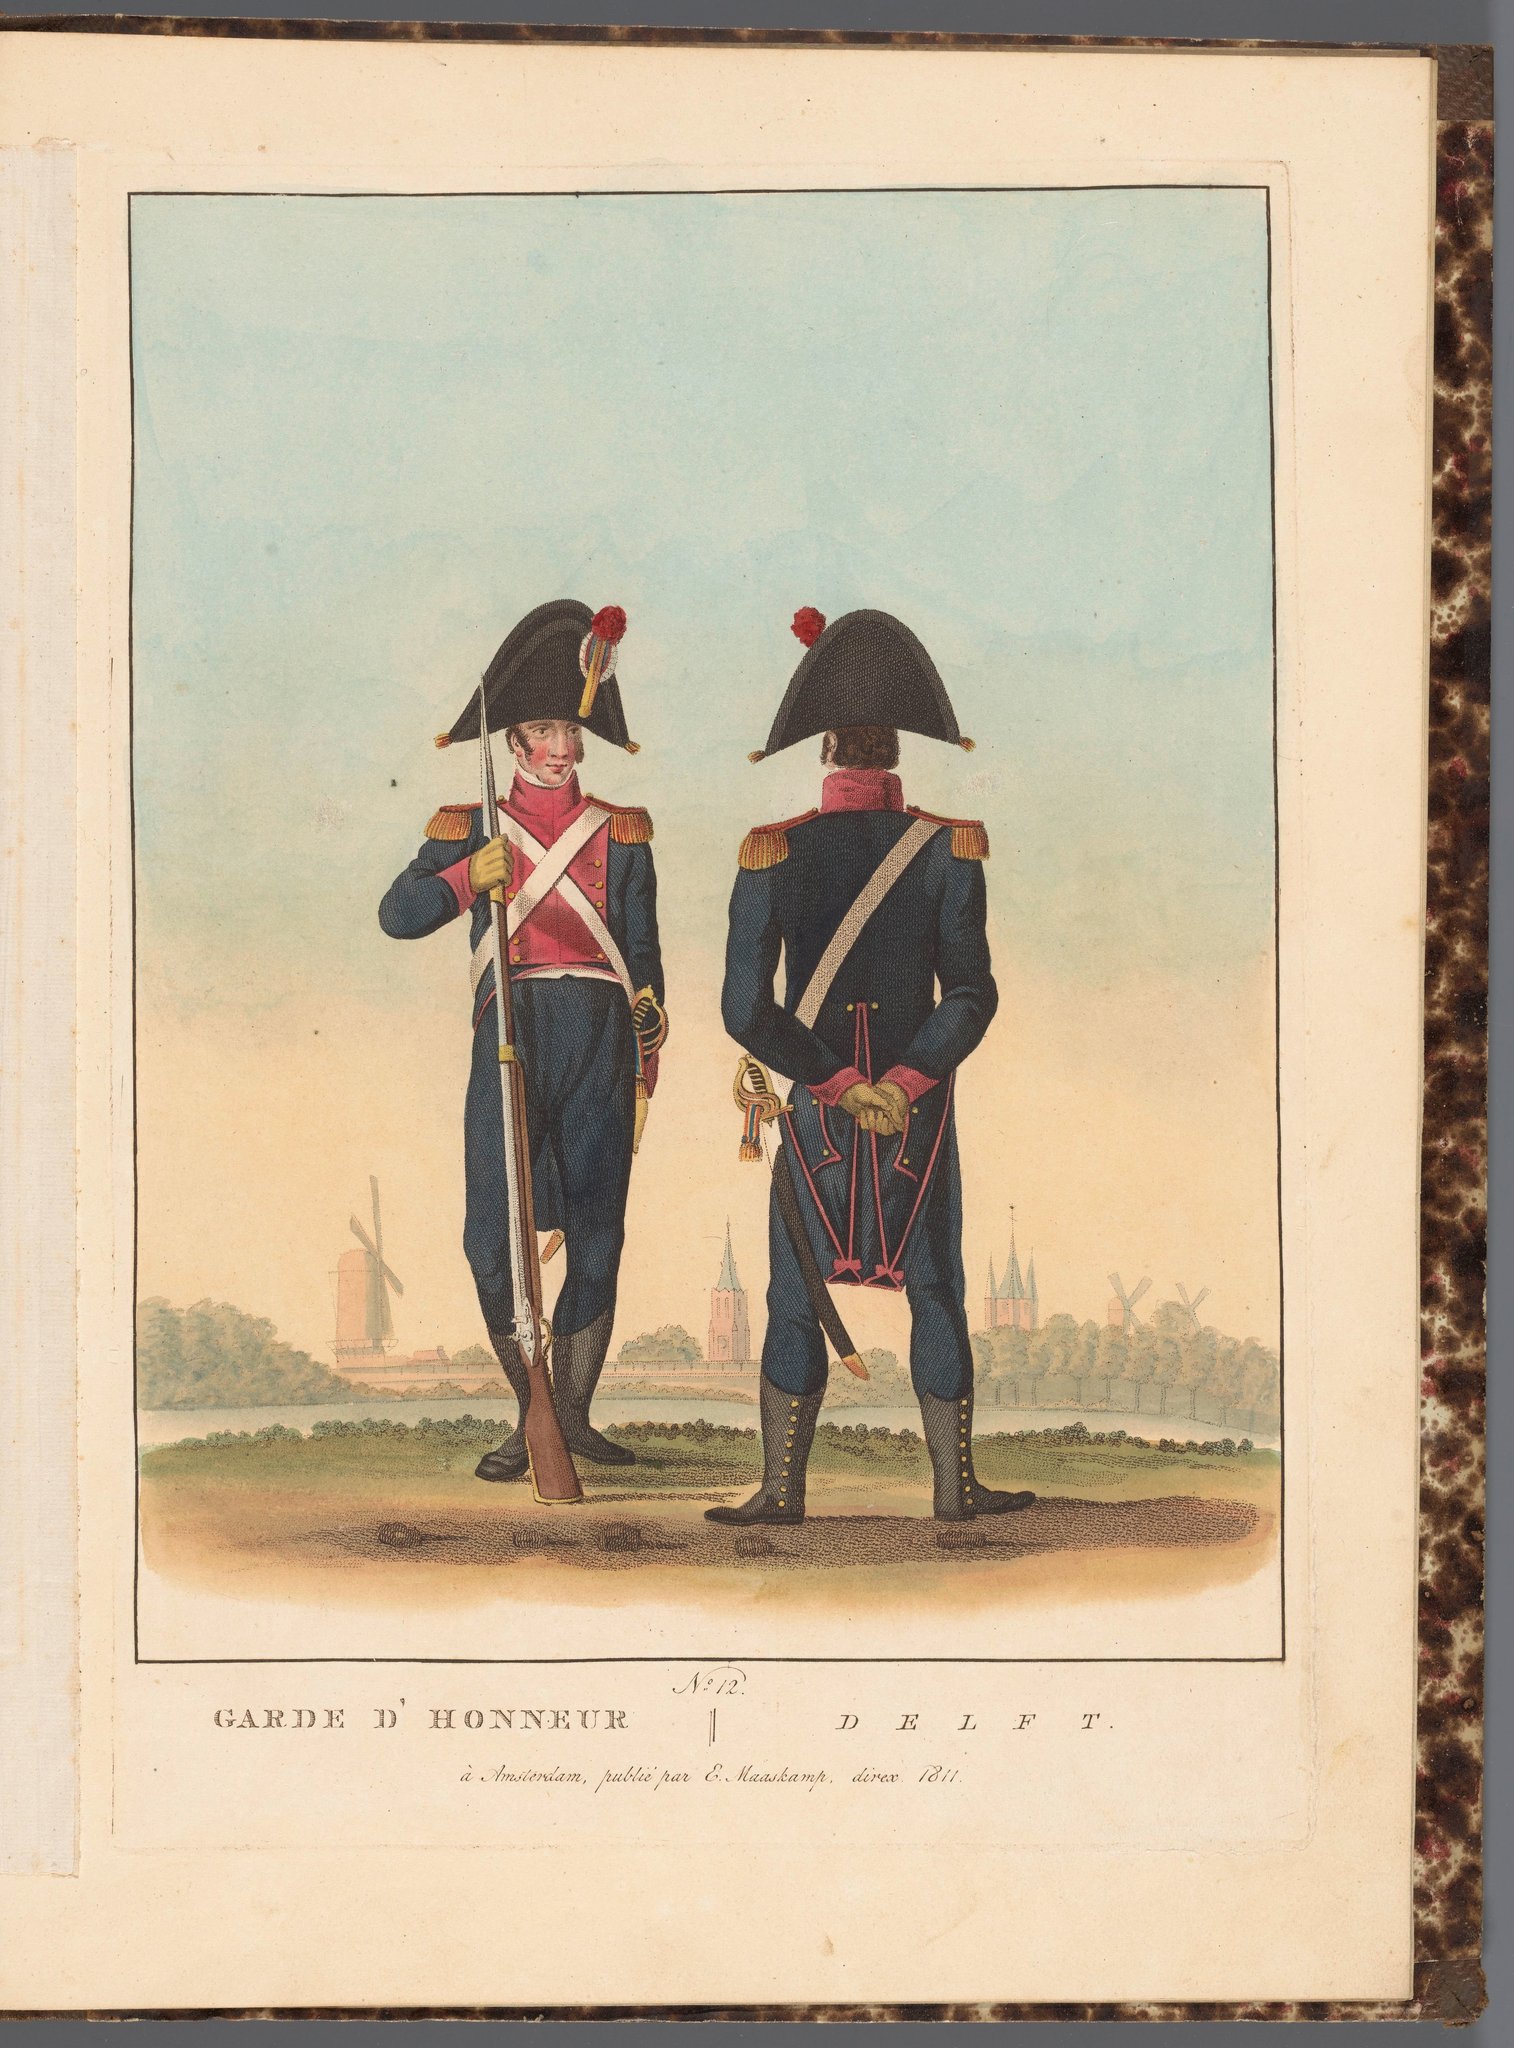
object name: costume print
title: Erewacht te Delft, 1811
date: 1811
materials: paper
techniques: etching, hand coloring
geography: netherlands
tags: napoleon i (emperor of the french), guard of honour, (military) uniforms, delft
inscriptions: date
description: Twee leden van de cavalerie van de erewacht te Delft. Onderdeel van het plaatwerk met twaalf platen van de verschillende uniformen van de erewachten in de zeven Nederlandse departementen, opgericht voor het bezoek van Napoleon Bonaparte aan Nederland in 1811.